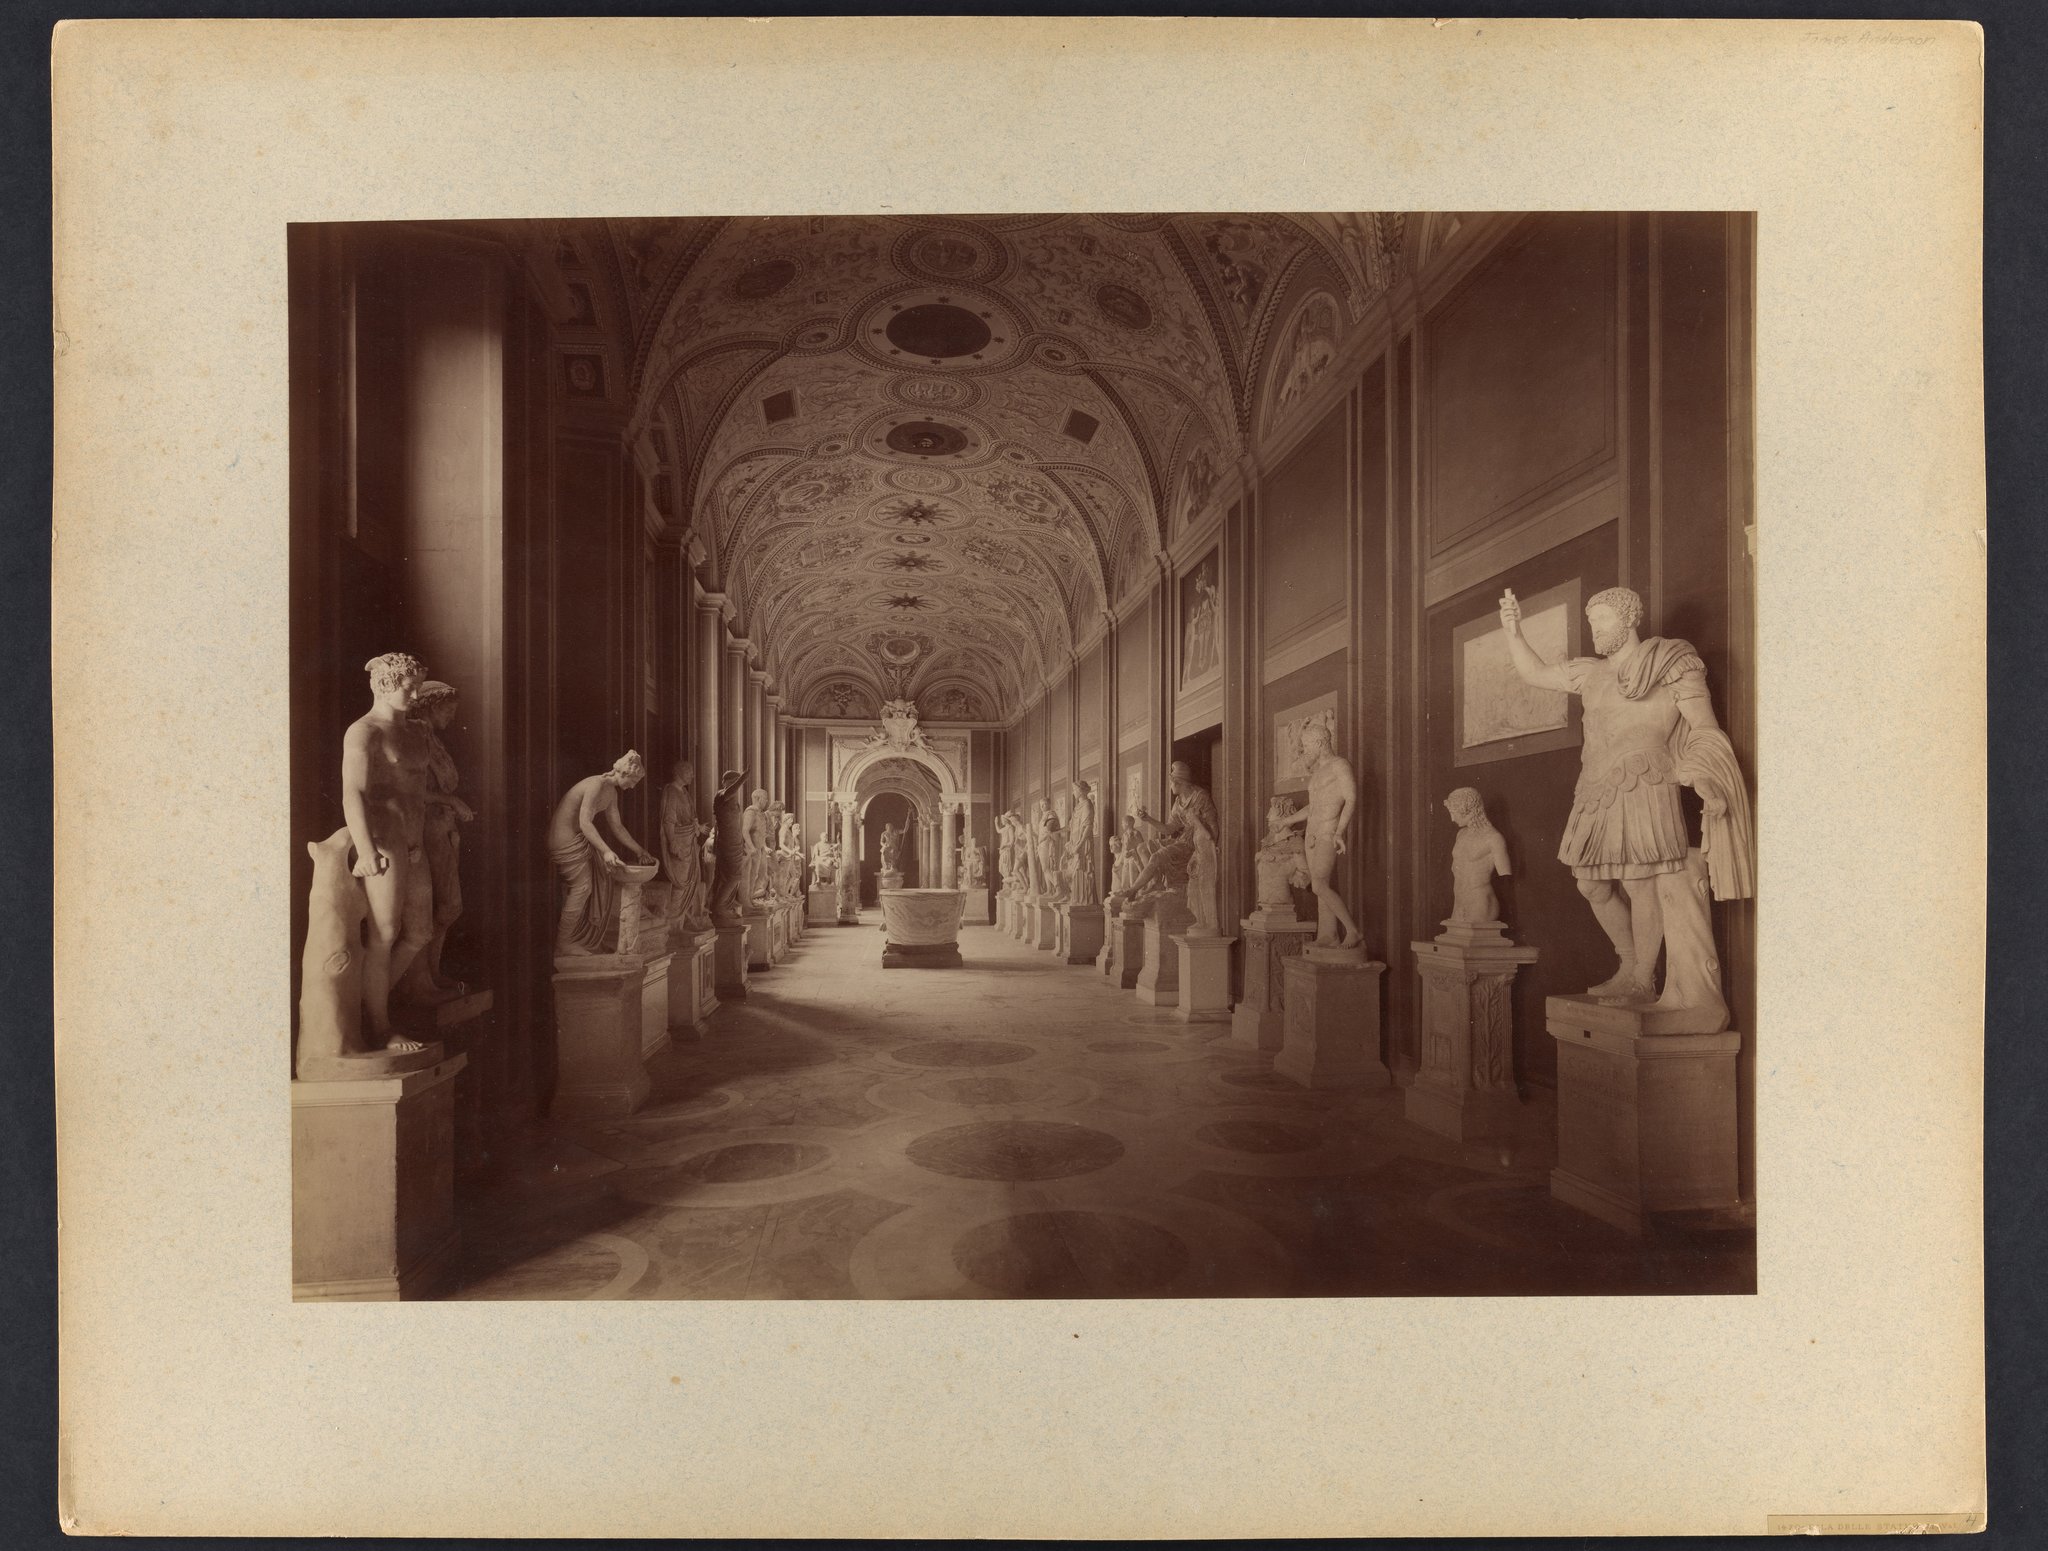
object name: photograph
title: Sala delle Statue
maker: james anderson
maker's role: fotograaf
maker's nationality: british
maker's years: 1813-1877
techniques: albumen silver print, glass negative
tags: sculpture